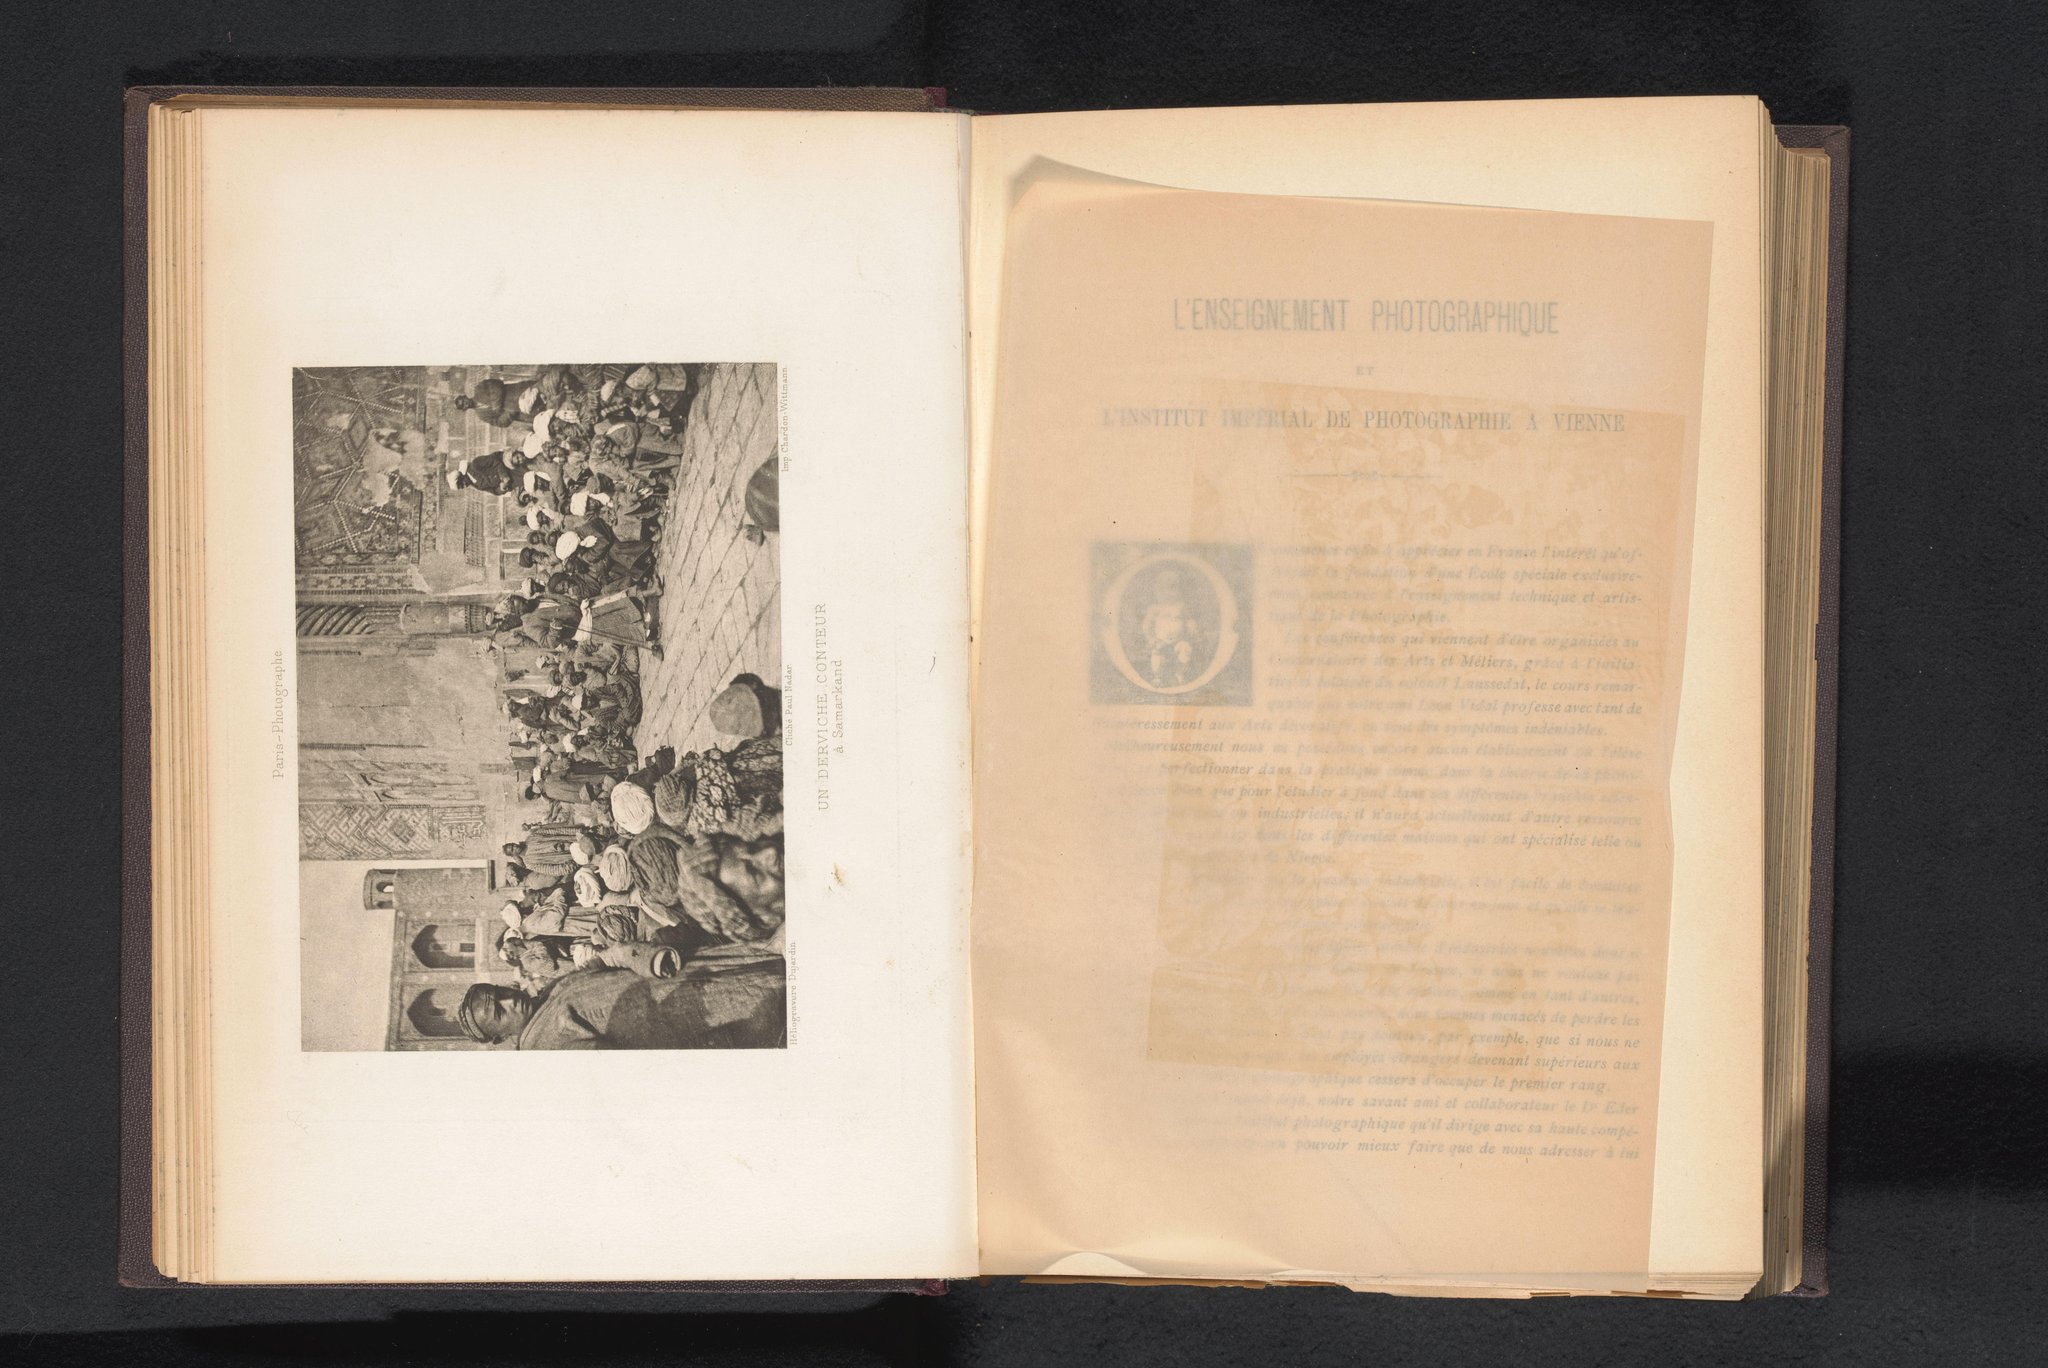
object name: photomechanical print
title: Un Derviche conteur à Samarkand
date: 1882-1892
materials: paper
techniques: photoaquatint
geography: samarqand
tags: story teller; listening to story teller